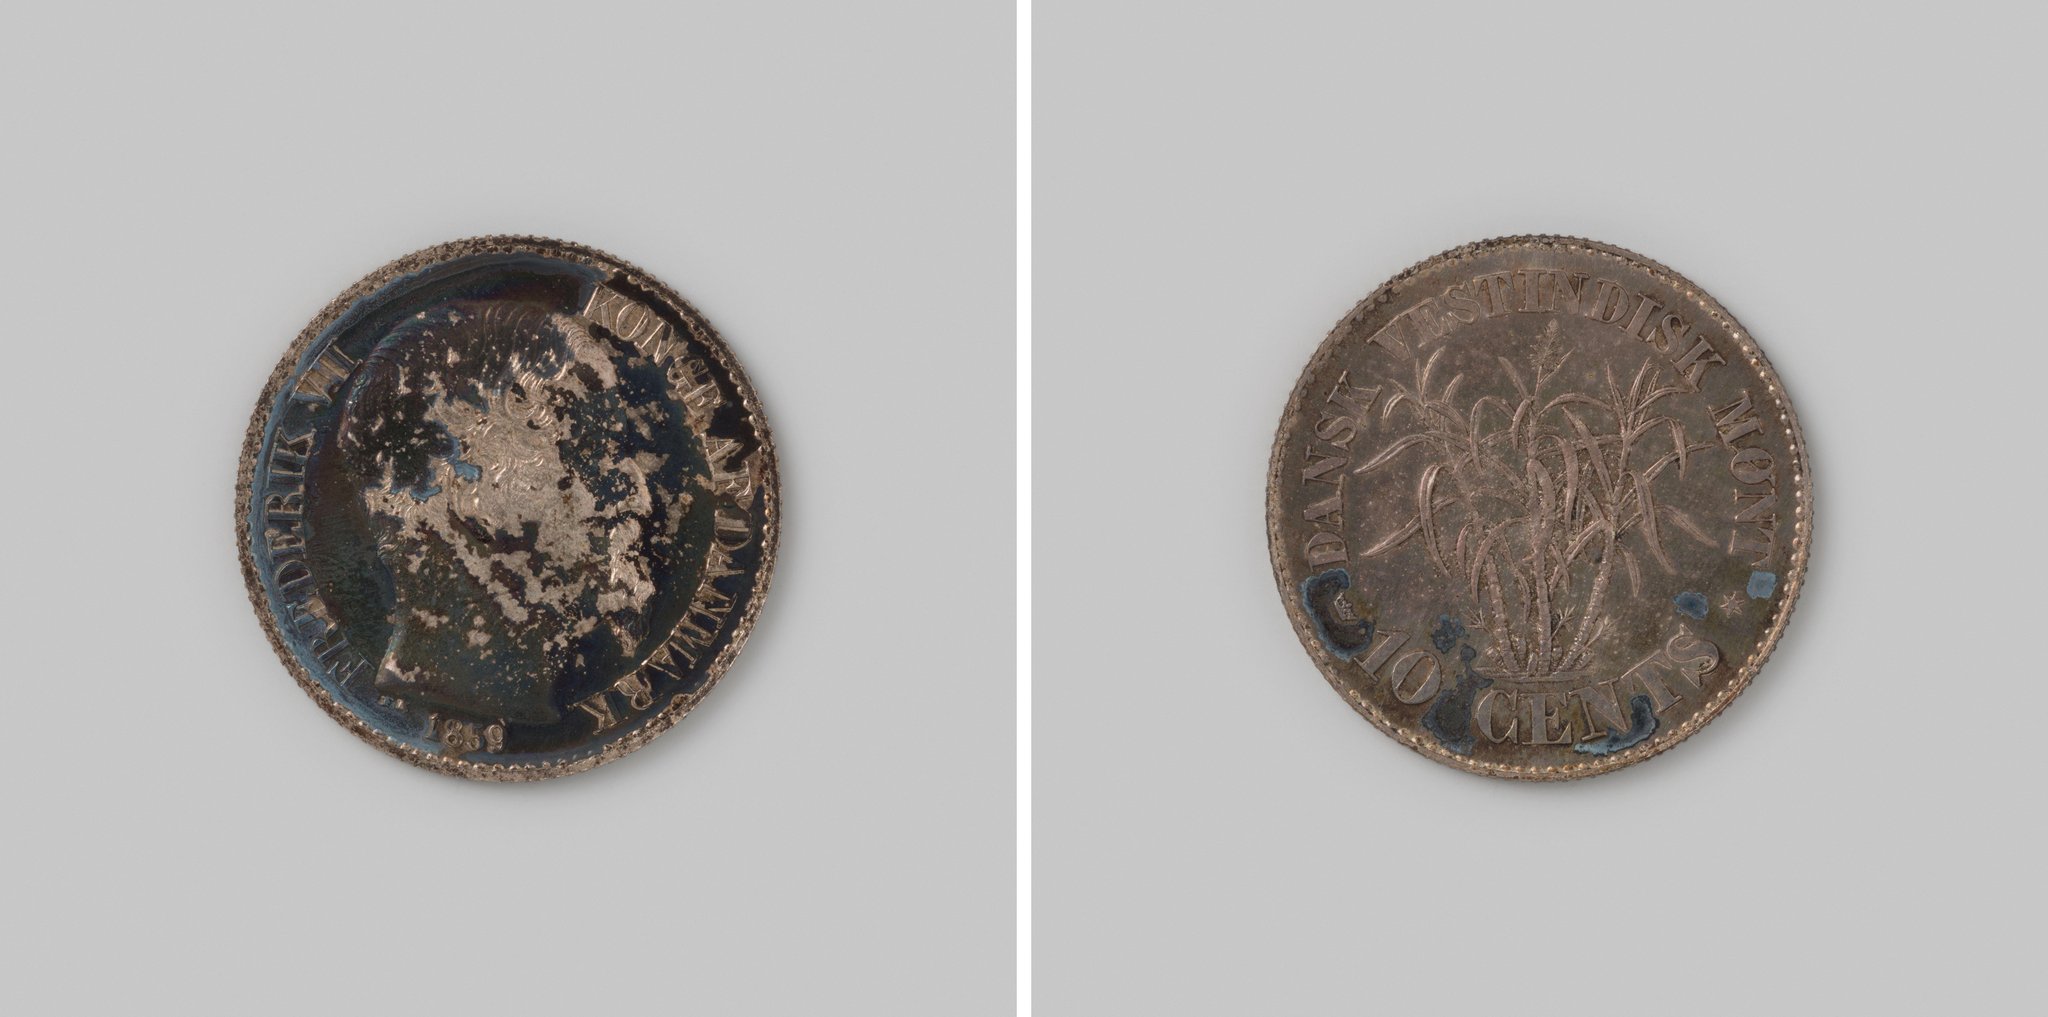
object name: coin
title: 10 cents uit Deens West-Indië van koning Frederik VII, 1859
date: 1859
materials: silver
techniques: striking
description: Zilveren munt. Voorzijde: hoofd van de koning naar rechts. Daaronder jaartal. Keerzijde: uit grond opschietend suikerriet. Waarde-aanduiding onderaan in omschrift. Kartelrand.